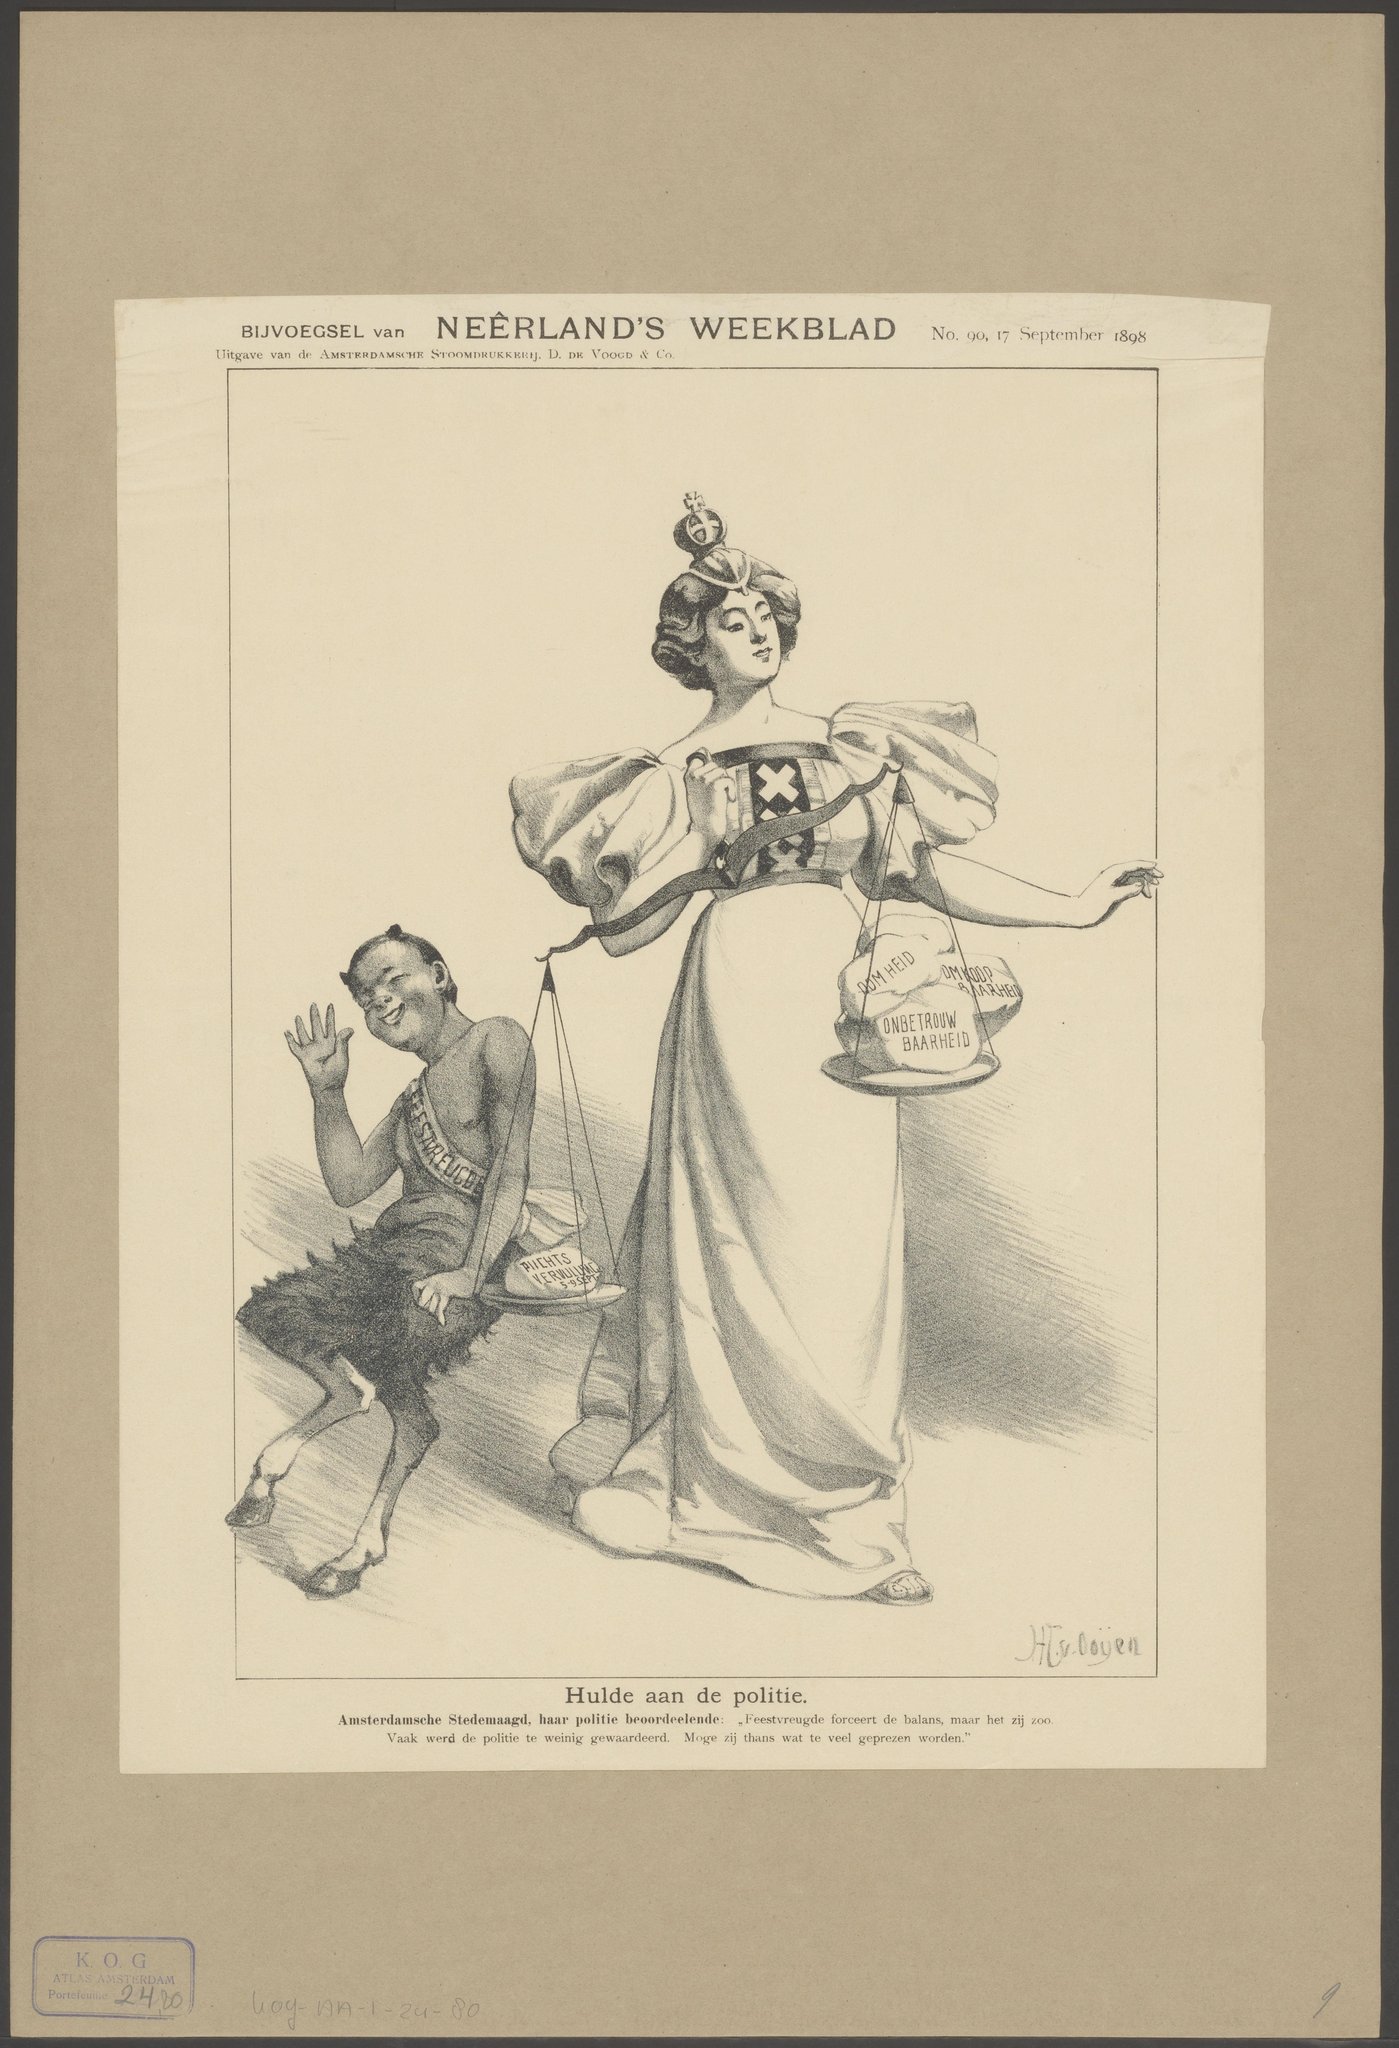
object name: cartoon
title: Amsterdamse stedenmaagd met een weegschaal en sater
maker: h. van ooijen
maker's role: print maker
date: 1898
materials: paper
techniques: letterpress printing, lithograph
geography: amsterdam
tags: personification of a city, town-patron(ess), scales, satyr(s) (in general), amsterdam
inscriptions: collector's mark: Lugt 1641b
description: Gepubliceerd als bijvoegsel van 'Neêrland's Weekblad', 17 september 1898.